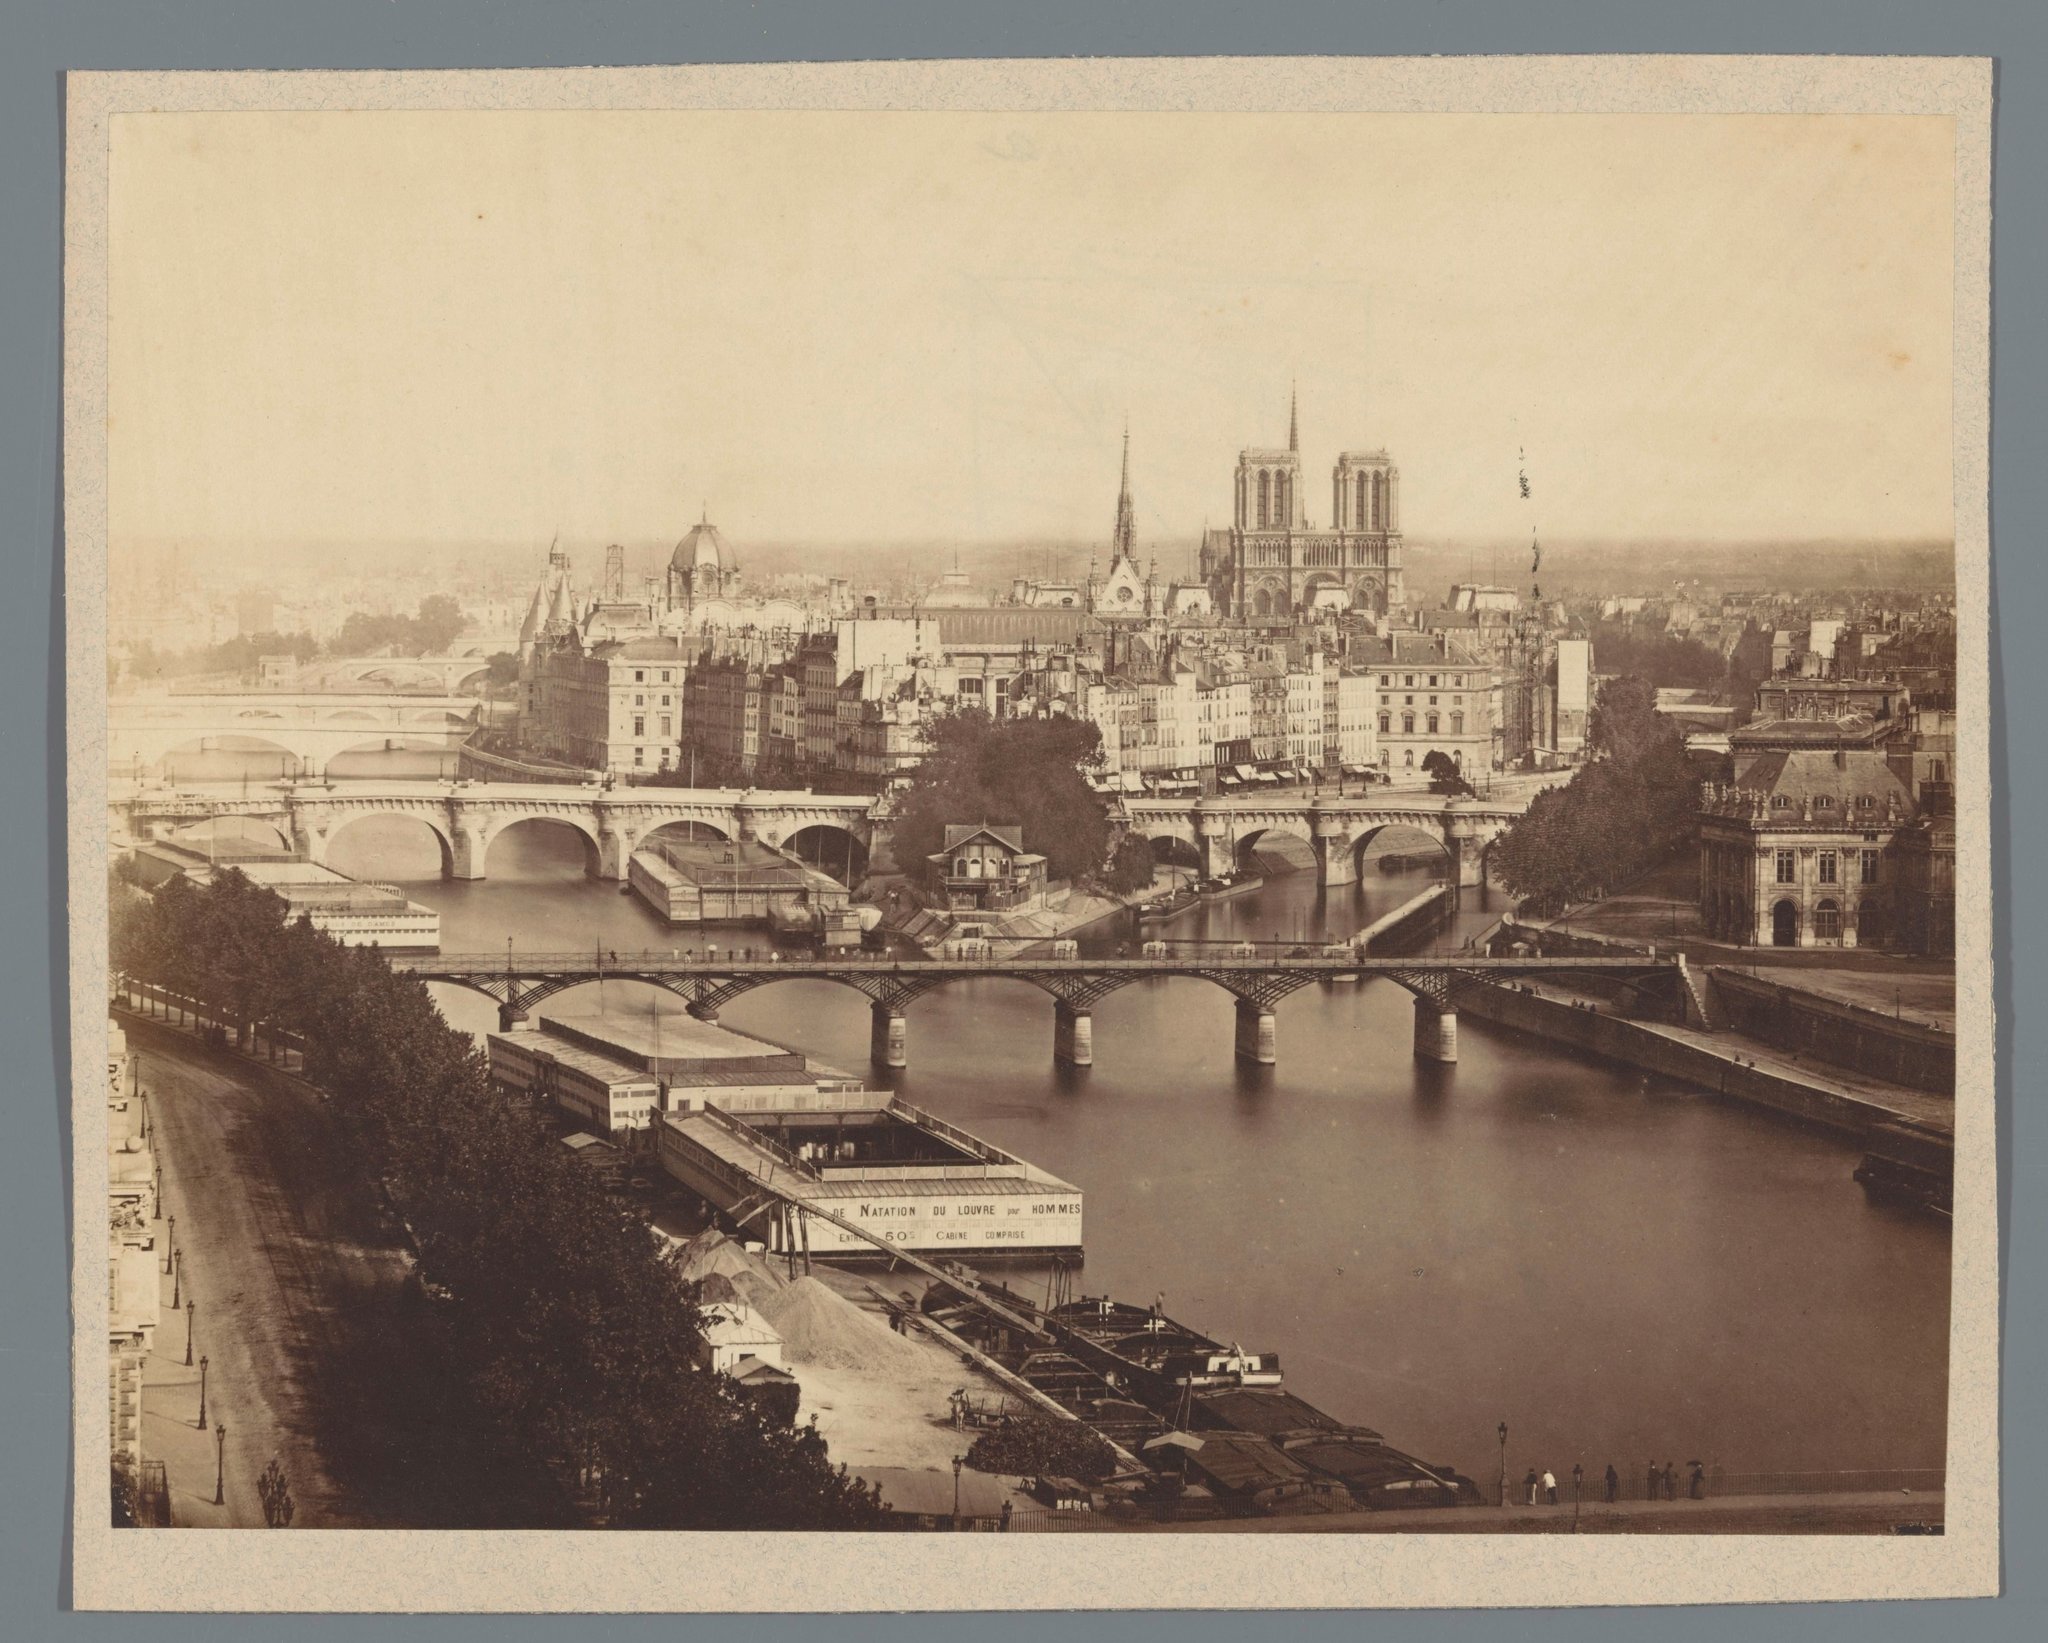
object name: photograph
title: Gezicht op het Île de la Cité te Parijs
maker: Anonymous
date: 1875-1900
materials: cardboard, photographic support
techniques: albumen print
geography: paris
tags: island, city-view in general; 'veduta', river, bridge